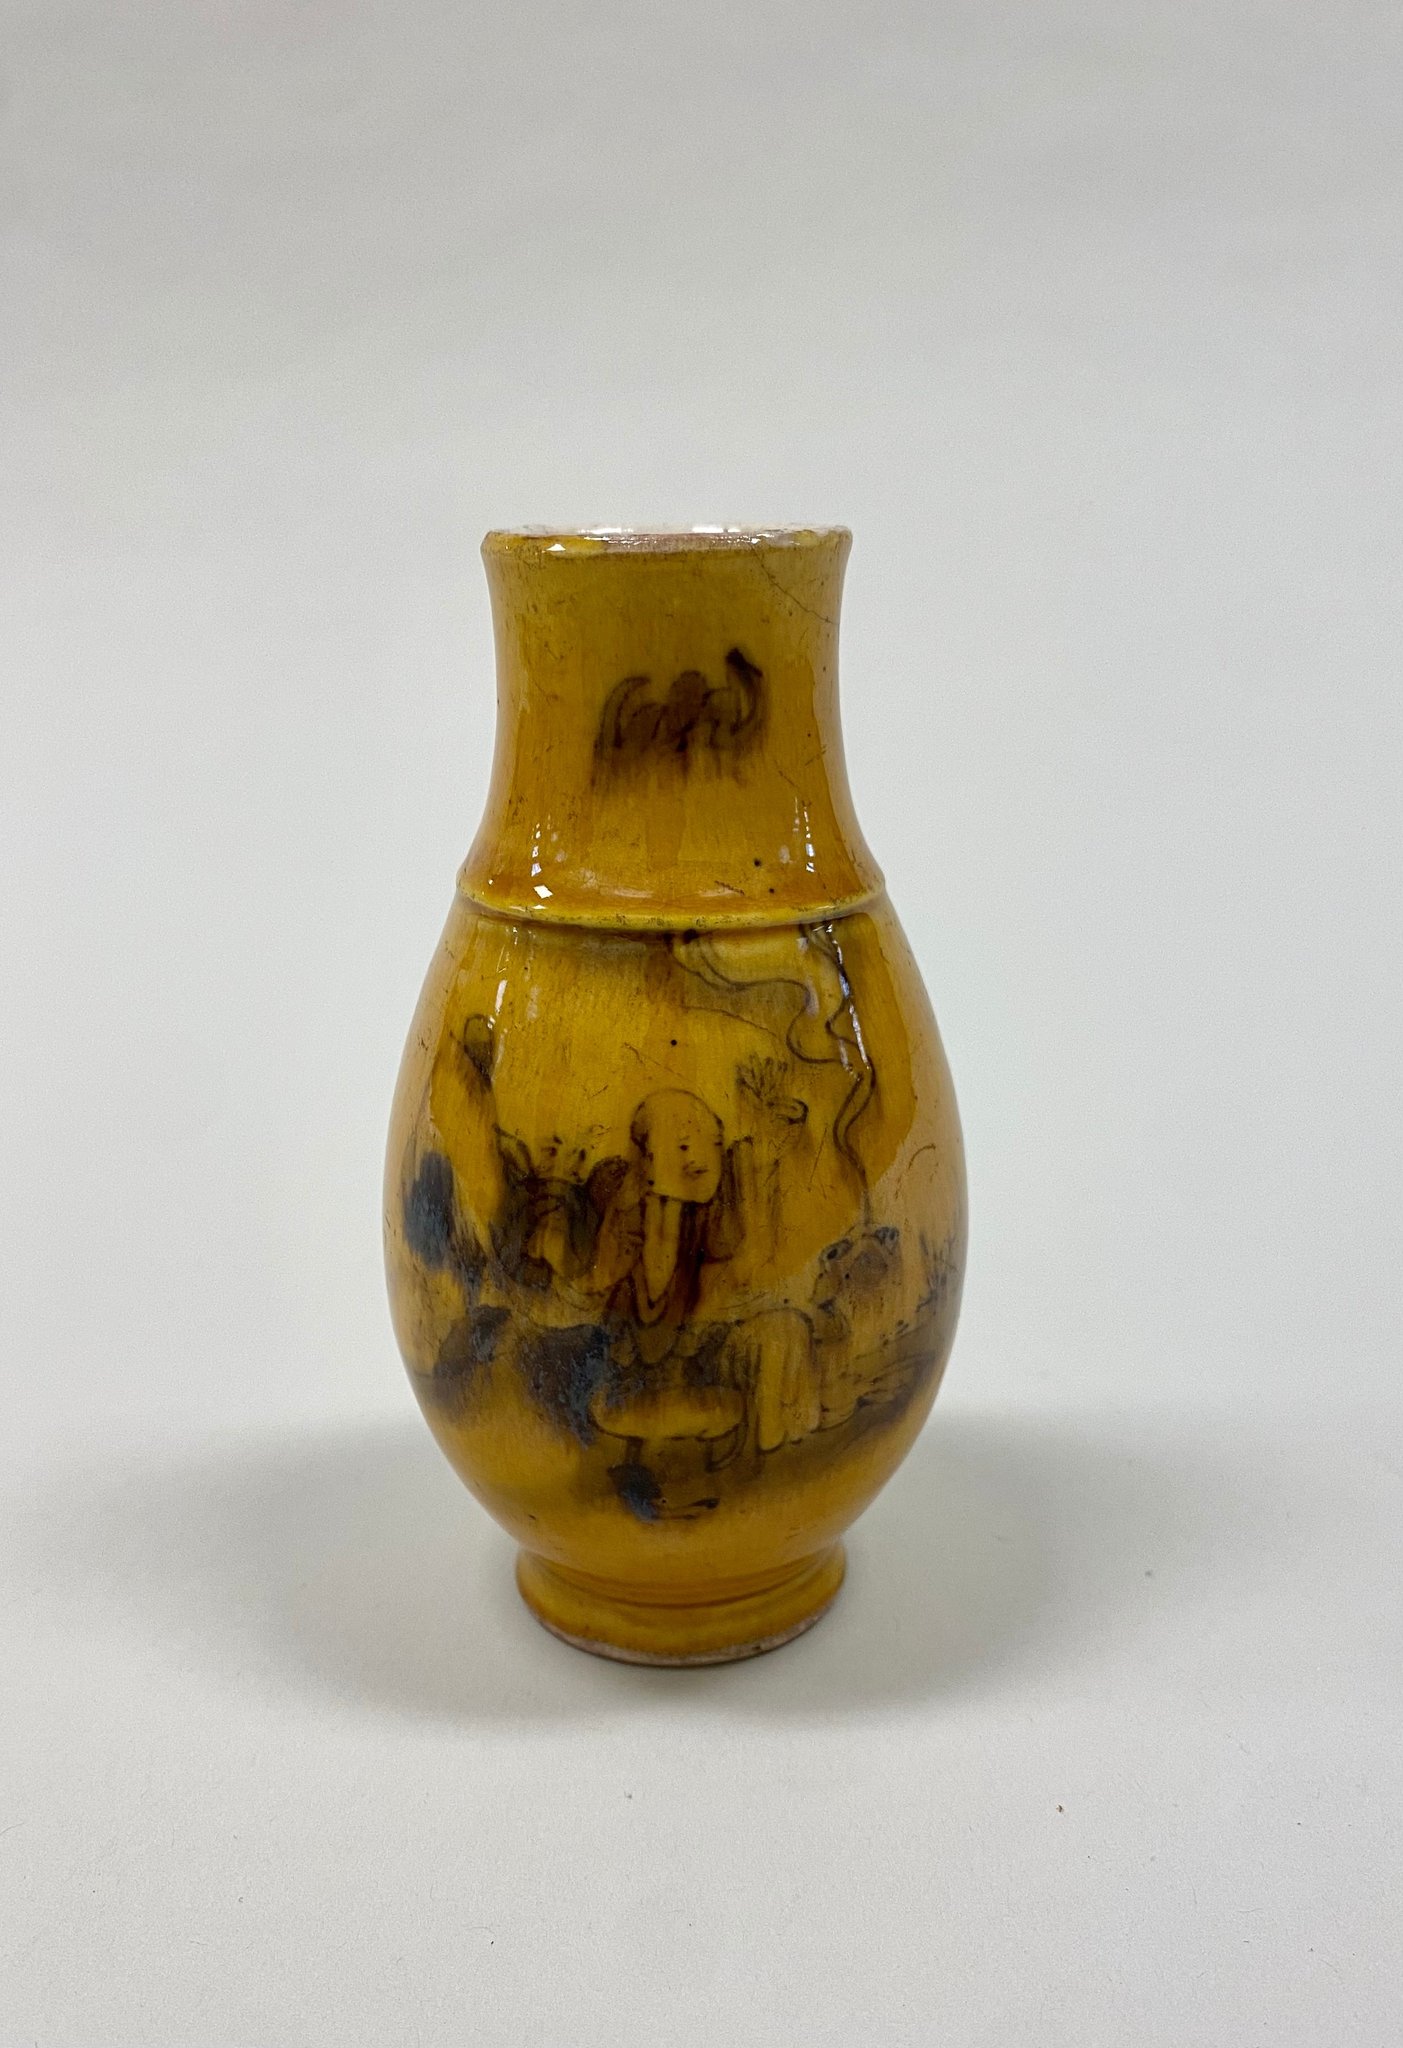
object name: vase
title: Vase with arhat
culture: chinese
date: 1801-1900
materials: cobalt, glaze, porcelain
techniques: painting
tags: men